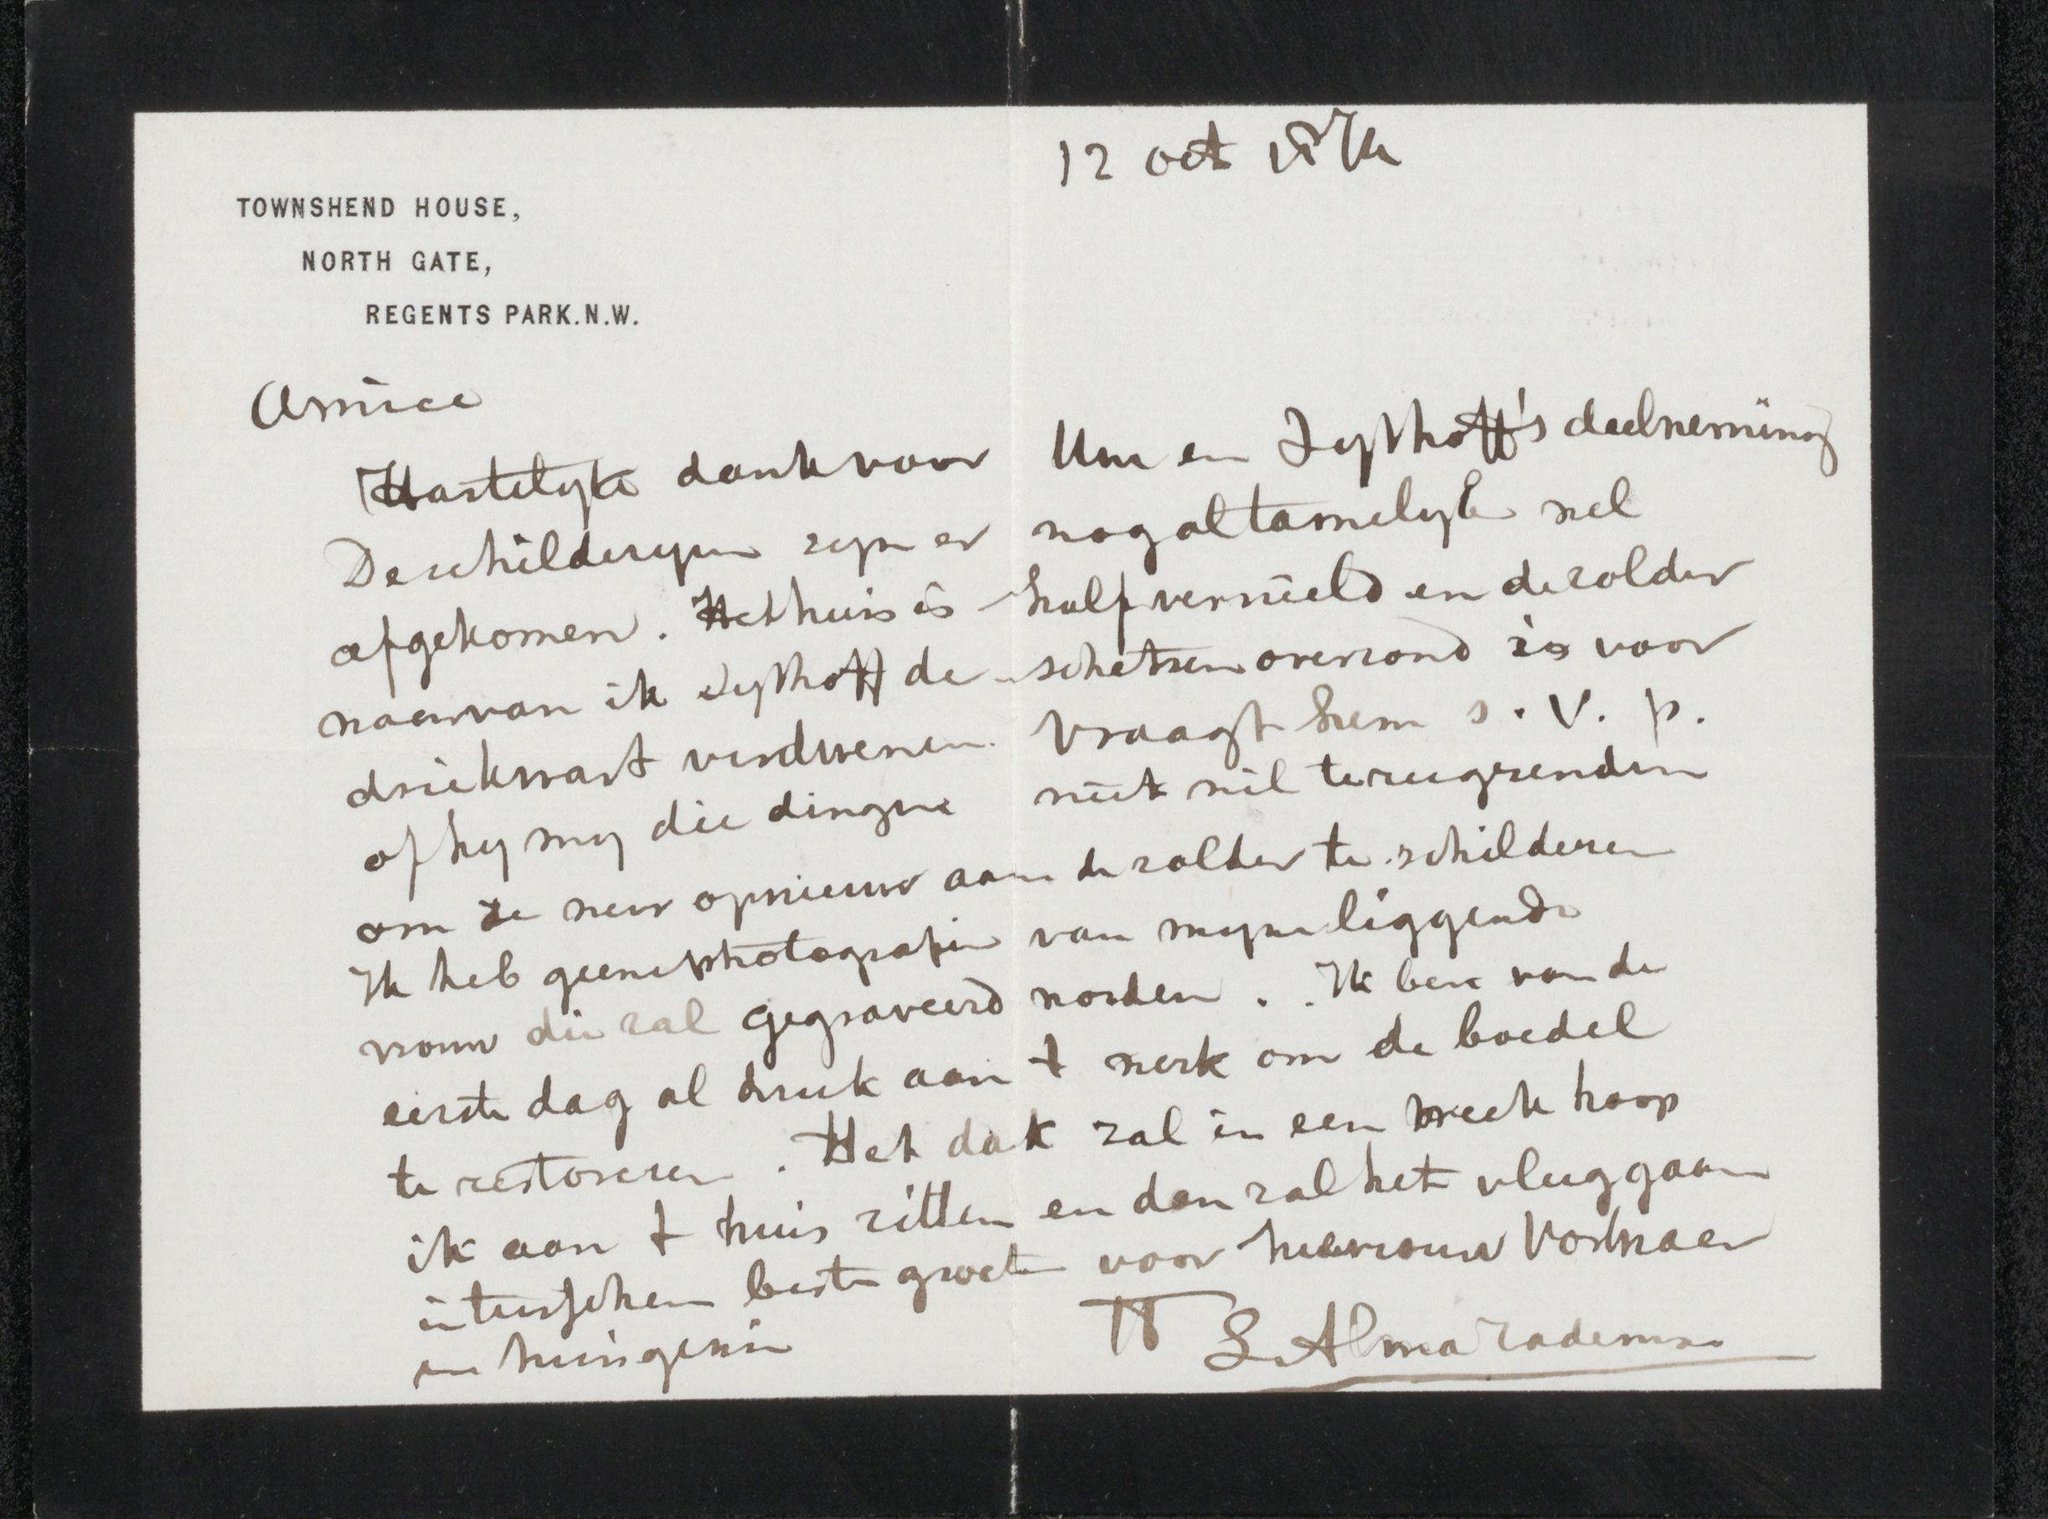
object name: letter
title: Brief aan Carel Vosmaer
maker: lourens alma tadema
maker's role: draughtsman, print maker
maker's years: 1836-1912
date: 1874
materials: ink, paper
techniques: pen, printing, writing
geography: london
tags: carel vosmaer, publisher, albertus willem sijthoff, drawing, photography, cinematography, painting (including book-illumination, miniature-painting)